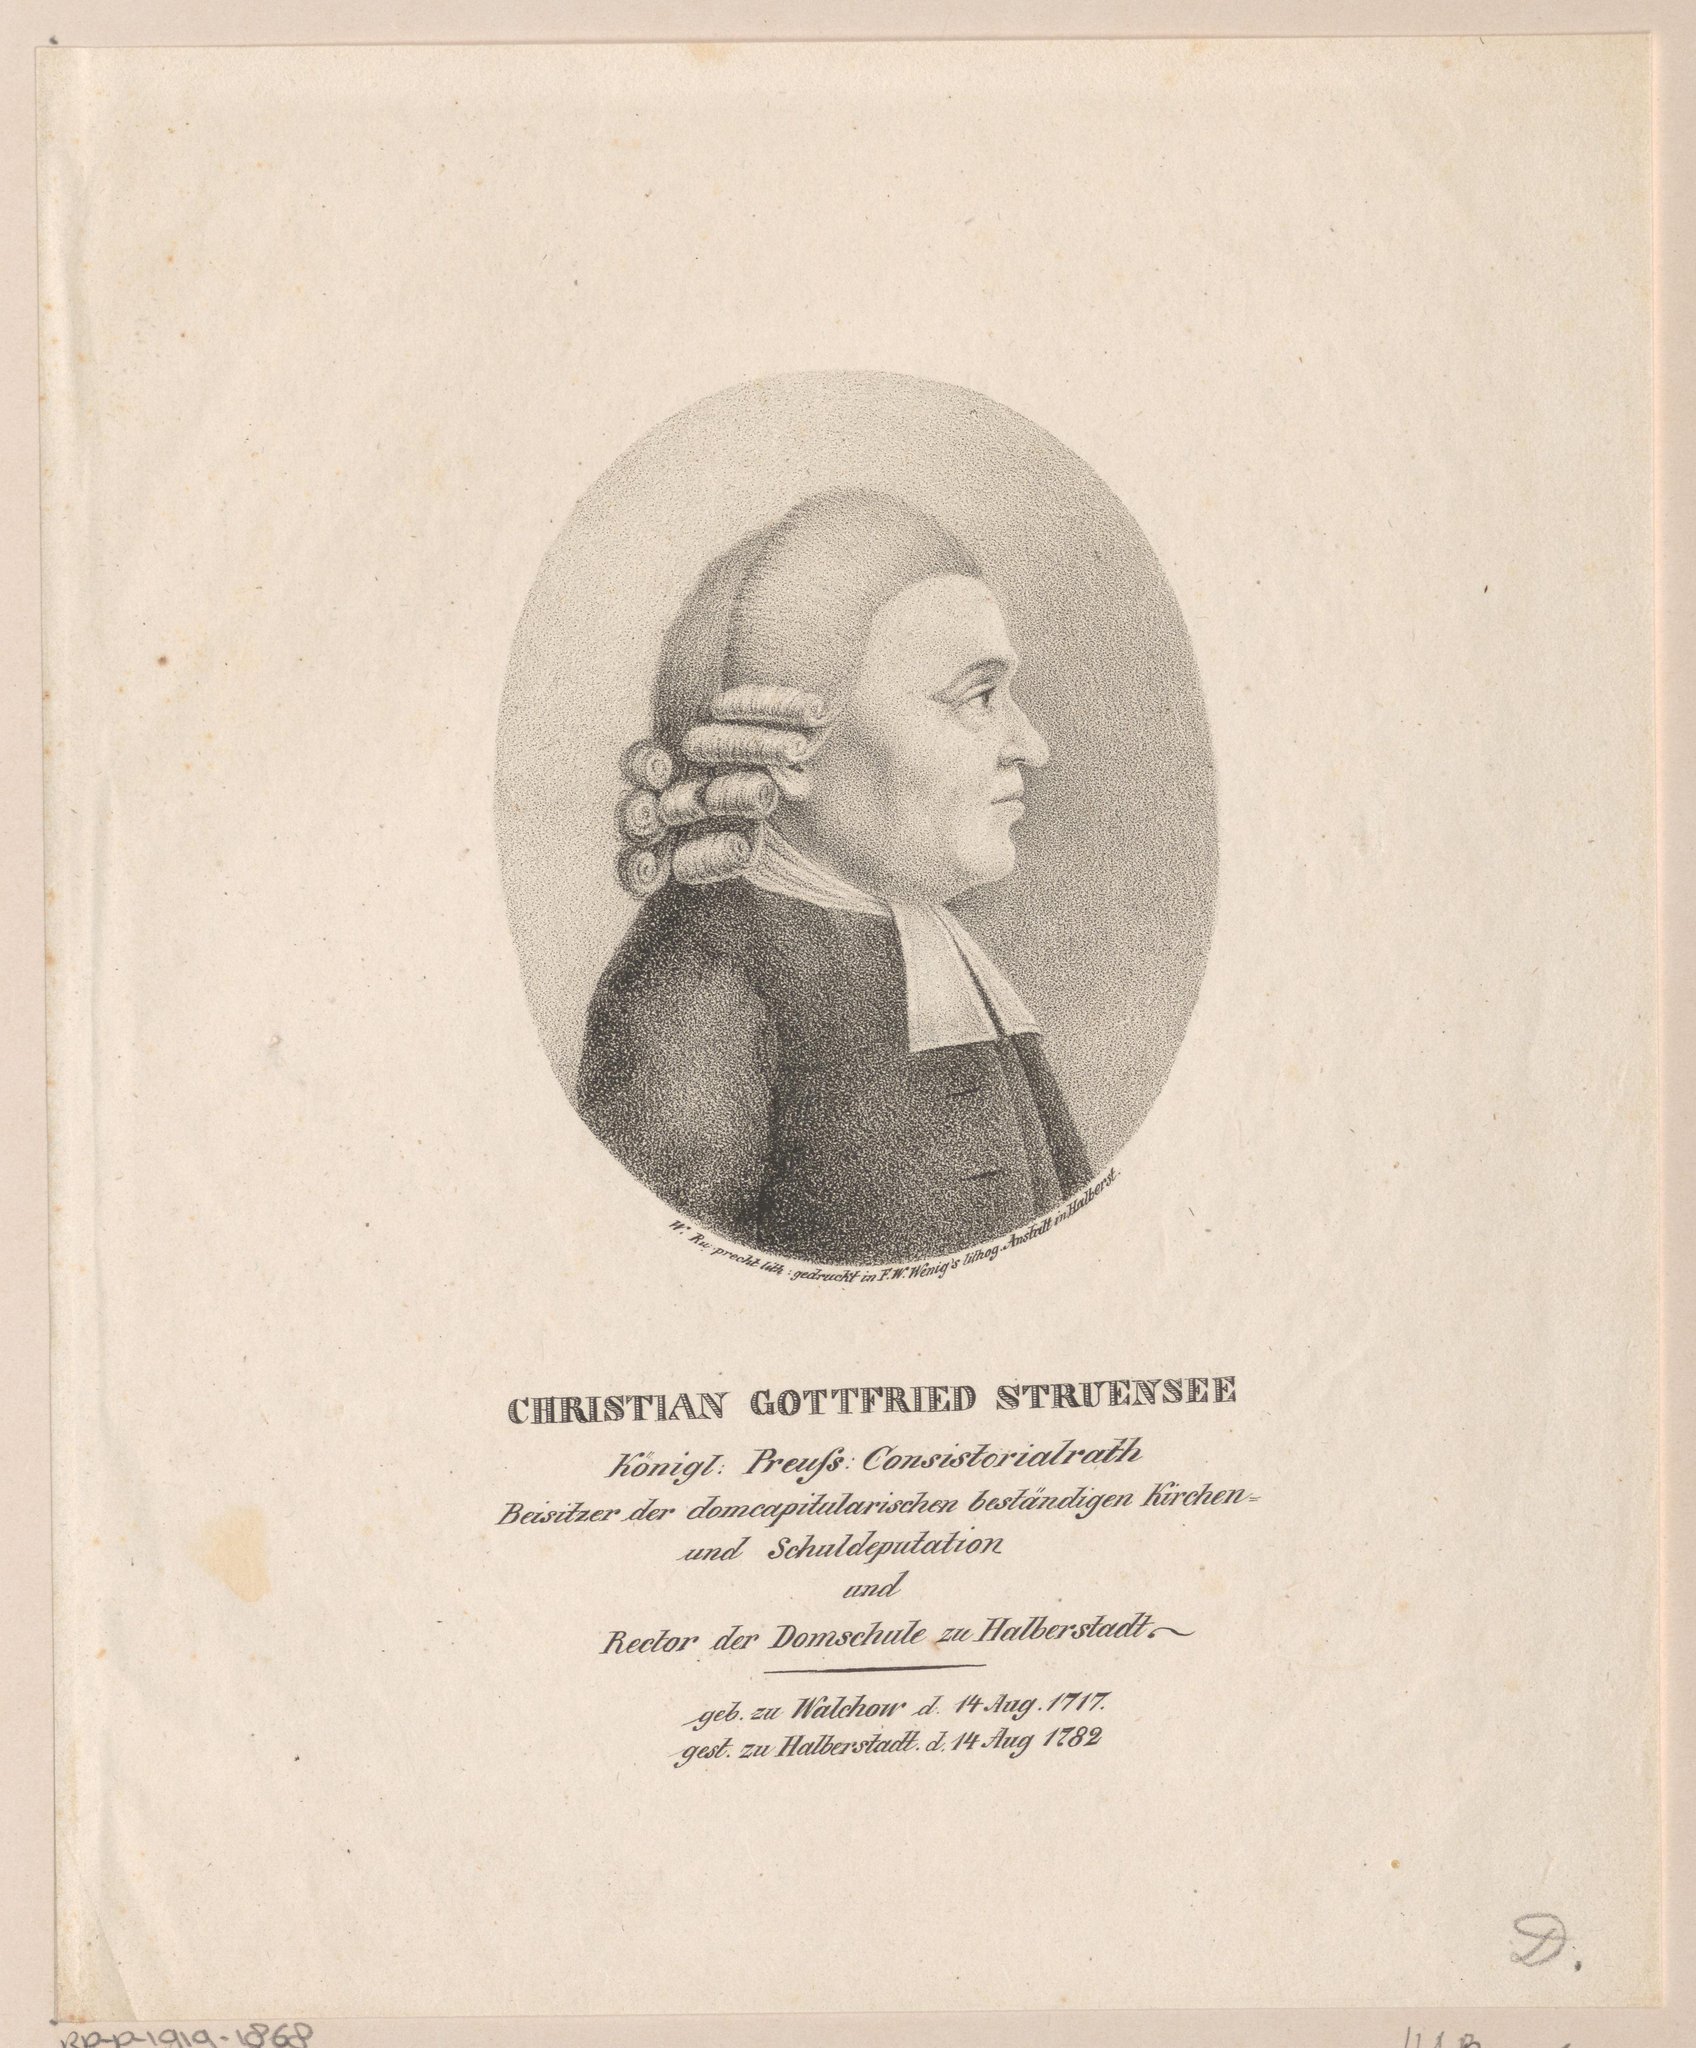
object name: print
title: Portret van Christian Gottfried Struensee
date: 1818-1844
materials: paper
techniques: lithograph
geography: halberstadt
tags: historical persons, professor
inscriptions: collector's mark: Lugt 2228